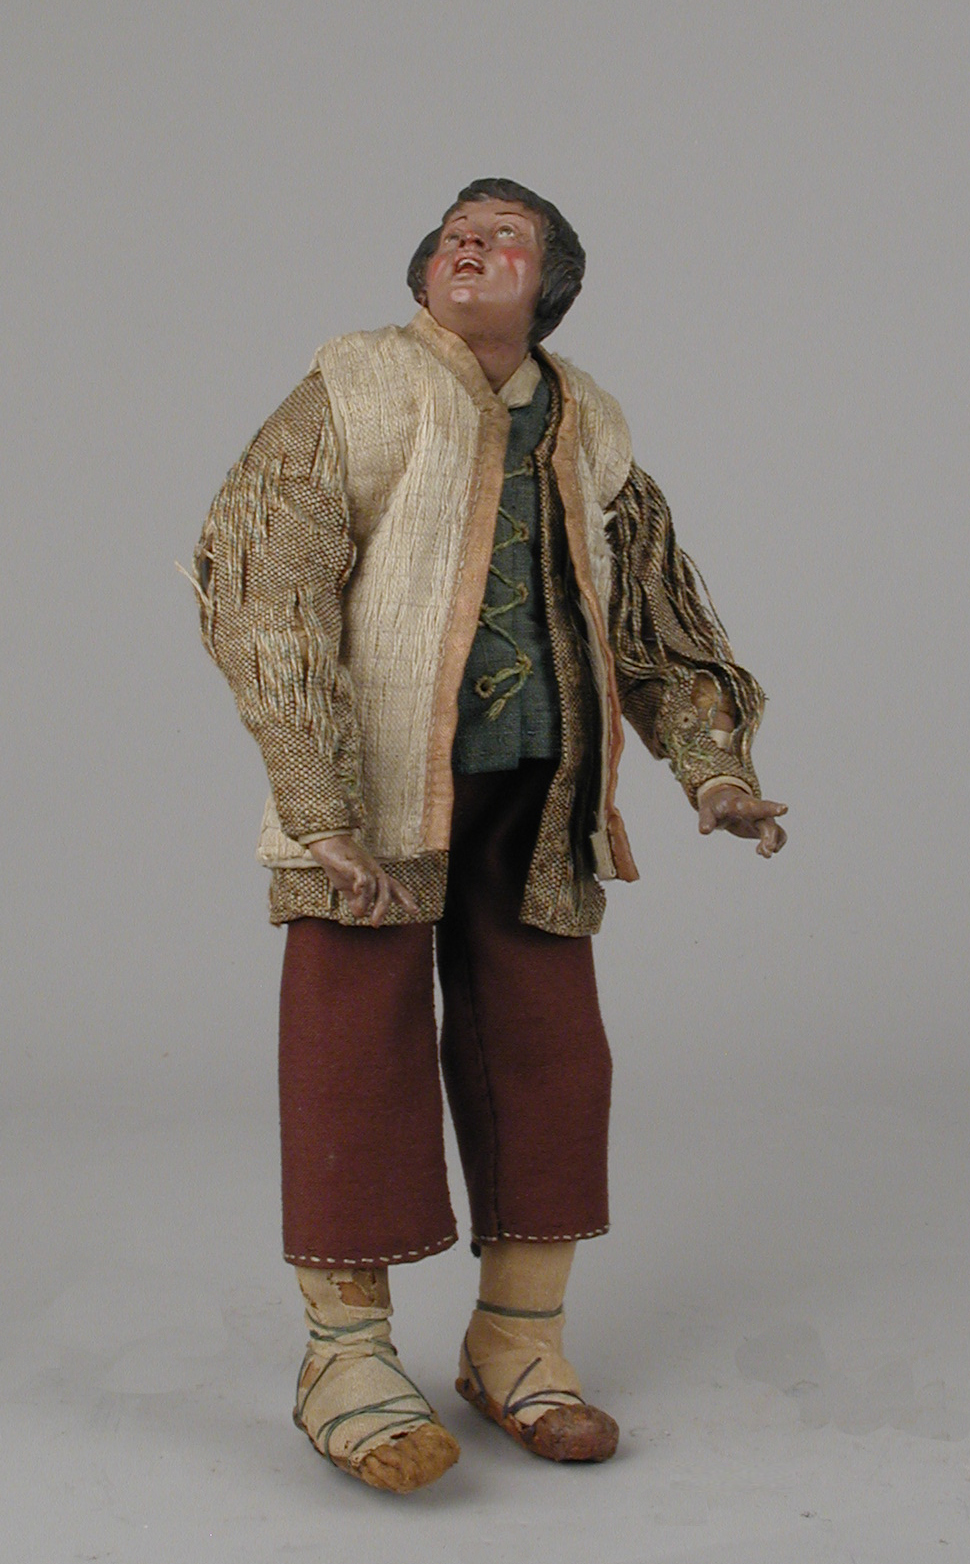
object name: crèche figure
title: Standing shepherd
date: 1801-1833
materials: textile, leather, terracotta, fiber, metal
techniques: polychrome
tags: men,shepherds